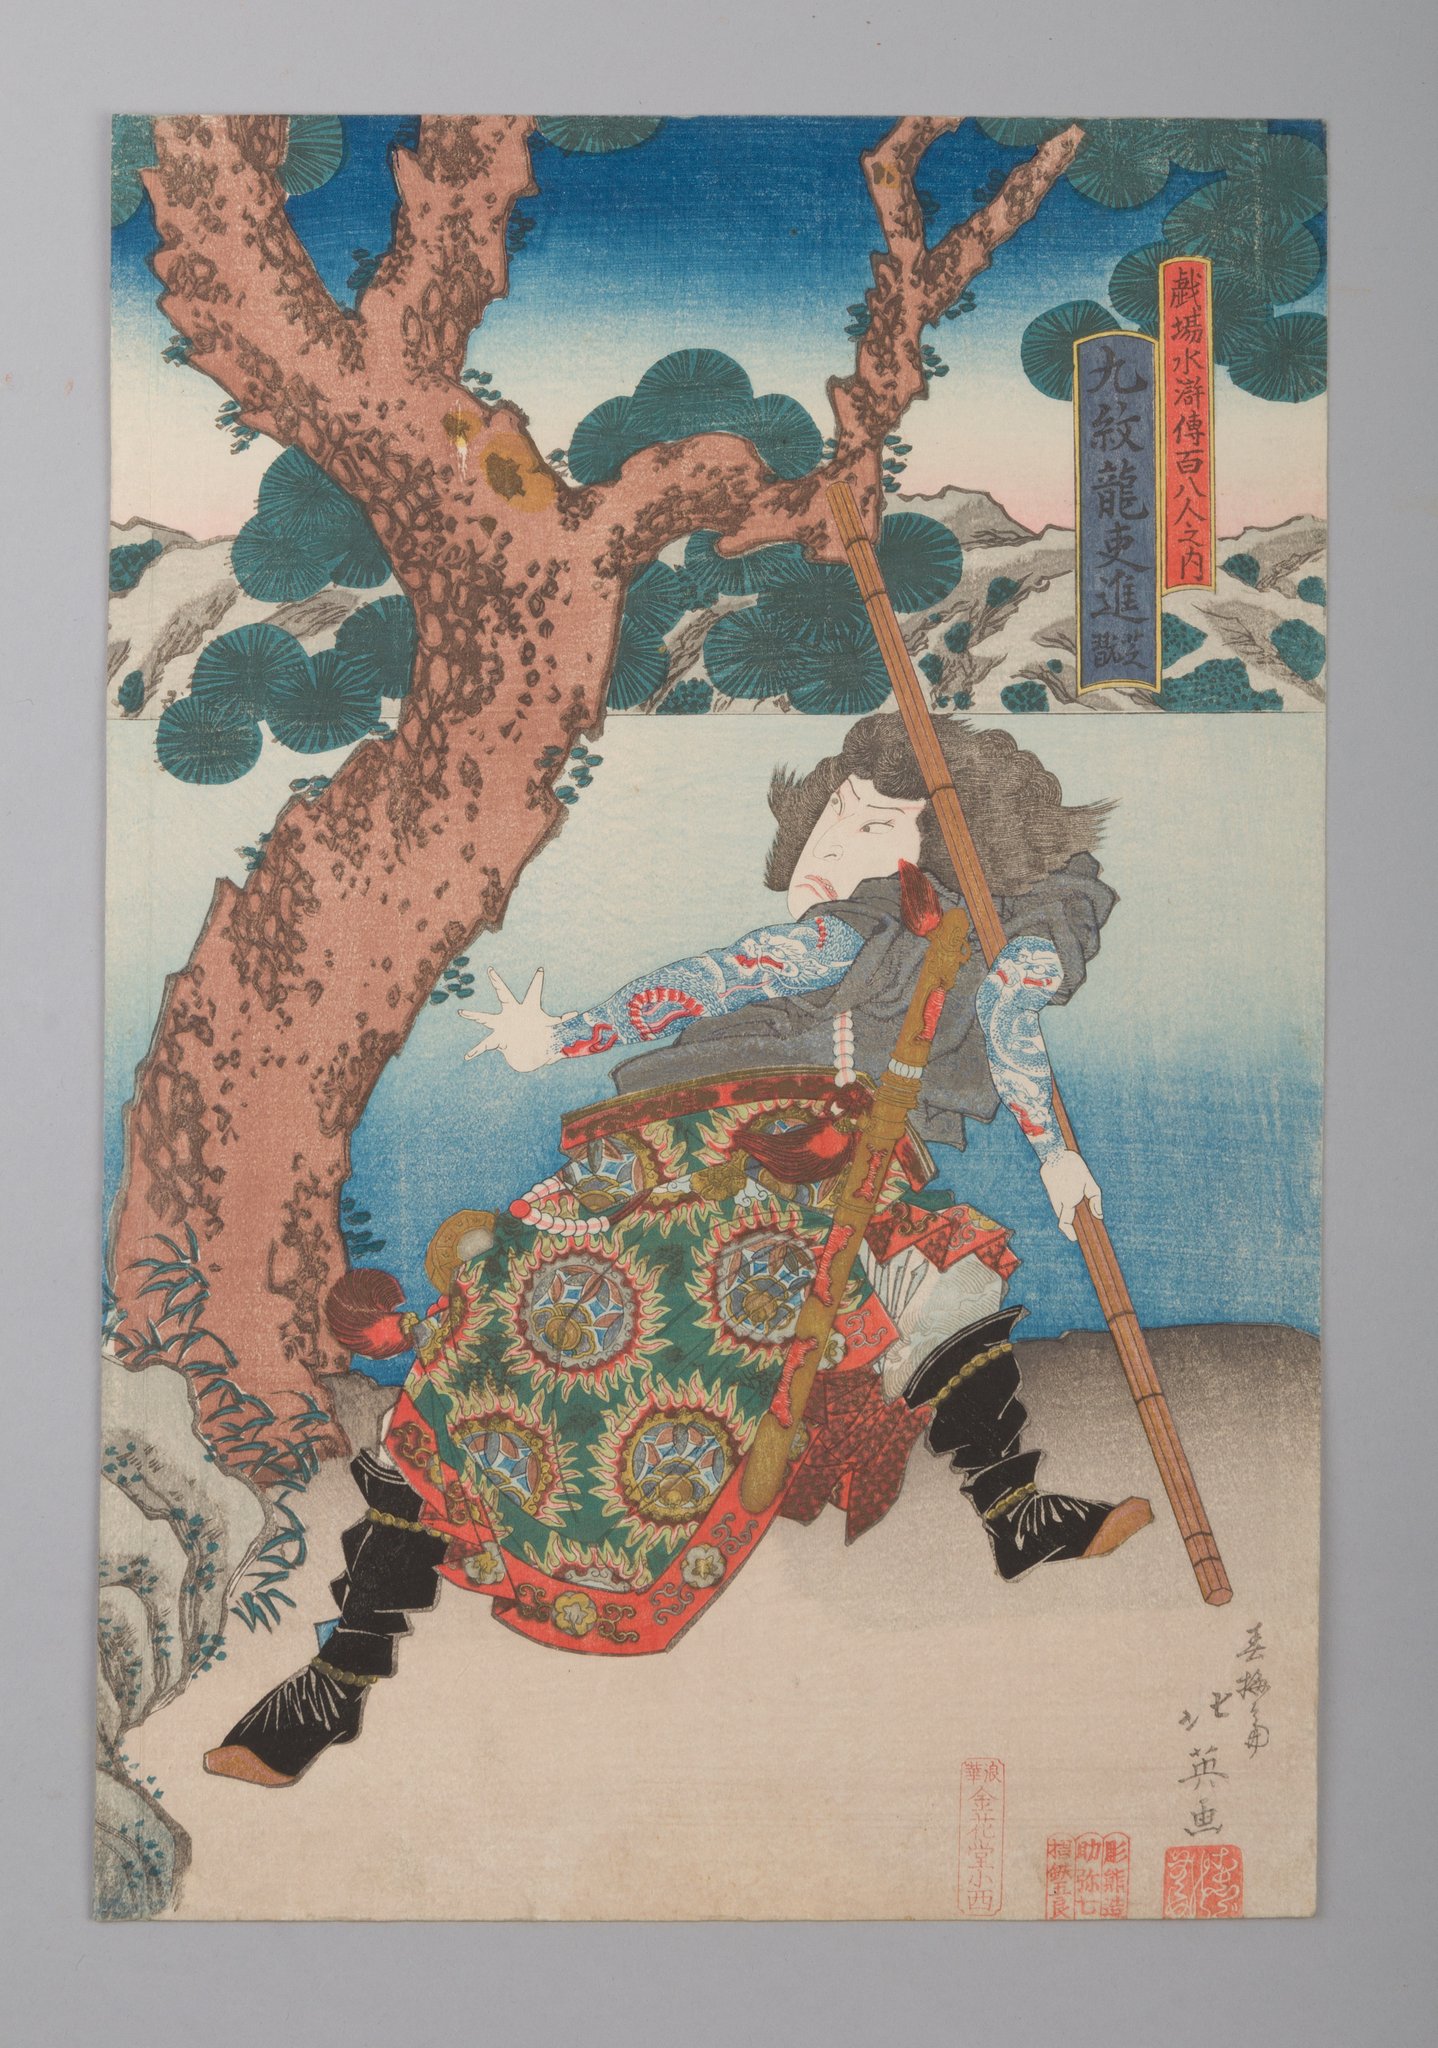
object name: woodblock print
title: Three Heroes of the Water Margin Capture the Bandit Queen Ichijōsei, from the series One Hundred Eight Heroes of the Theater Suikoden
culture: japanese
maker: shunbaisai hokuei 春梅斎北英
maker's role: artist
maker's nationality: japanese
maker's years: 1829-1837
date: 1835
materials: ink, paper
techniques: nishiki e, woodblock print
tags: swords,men